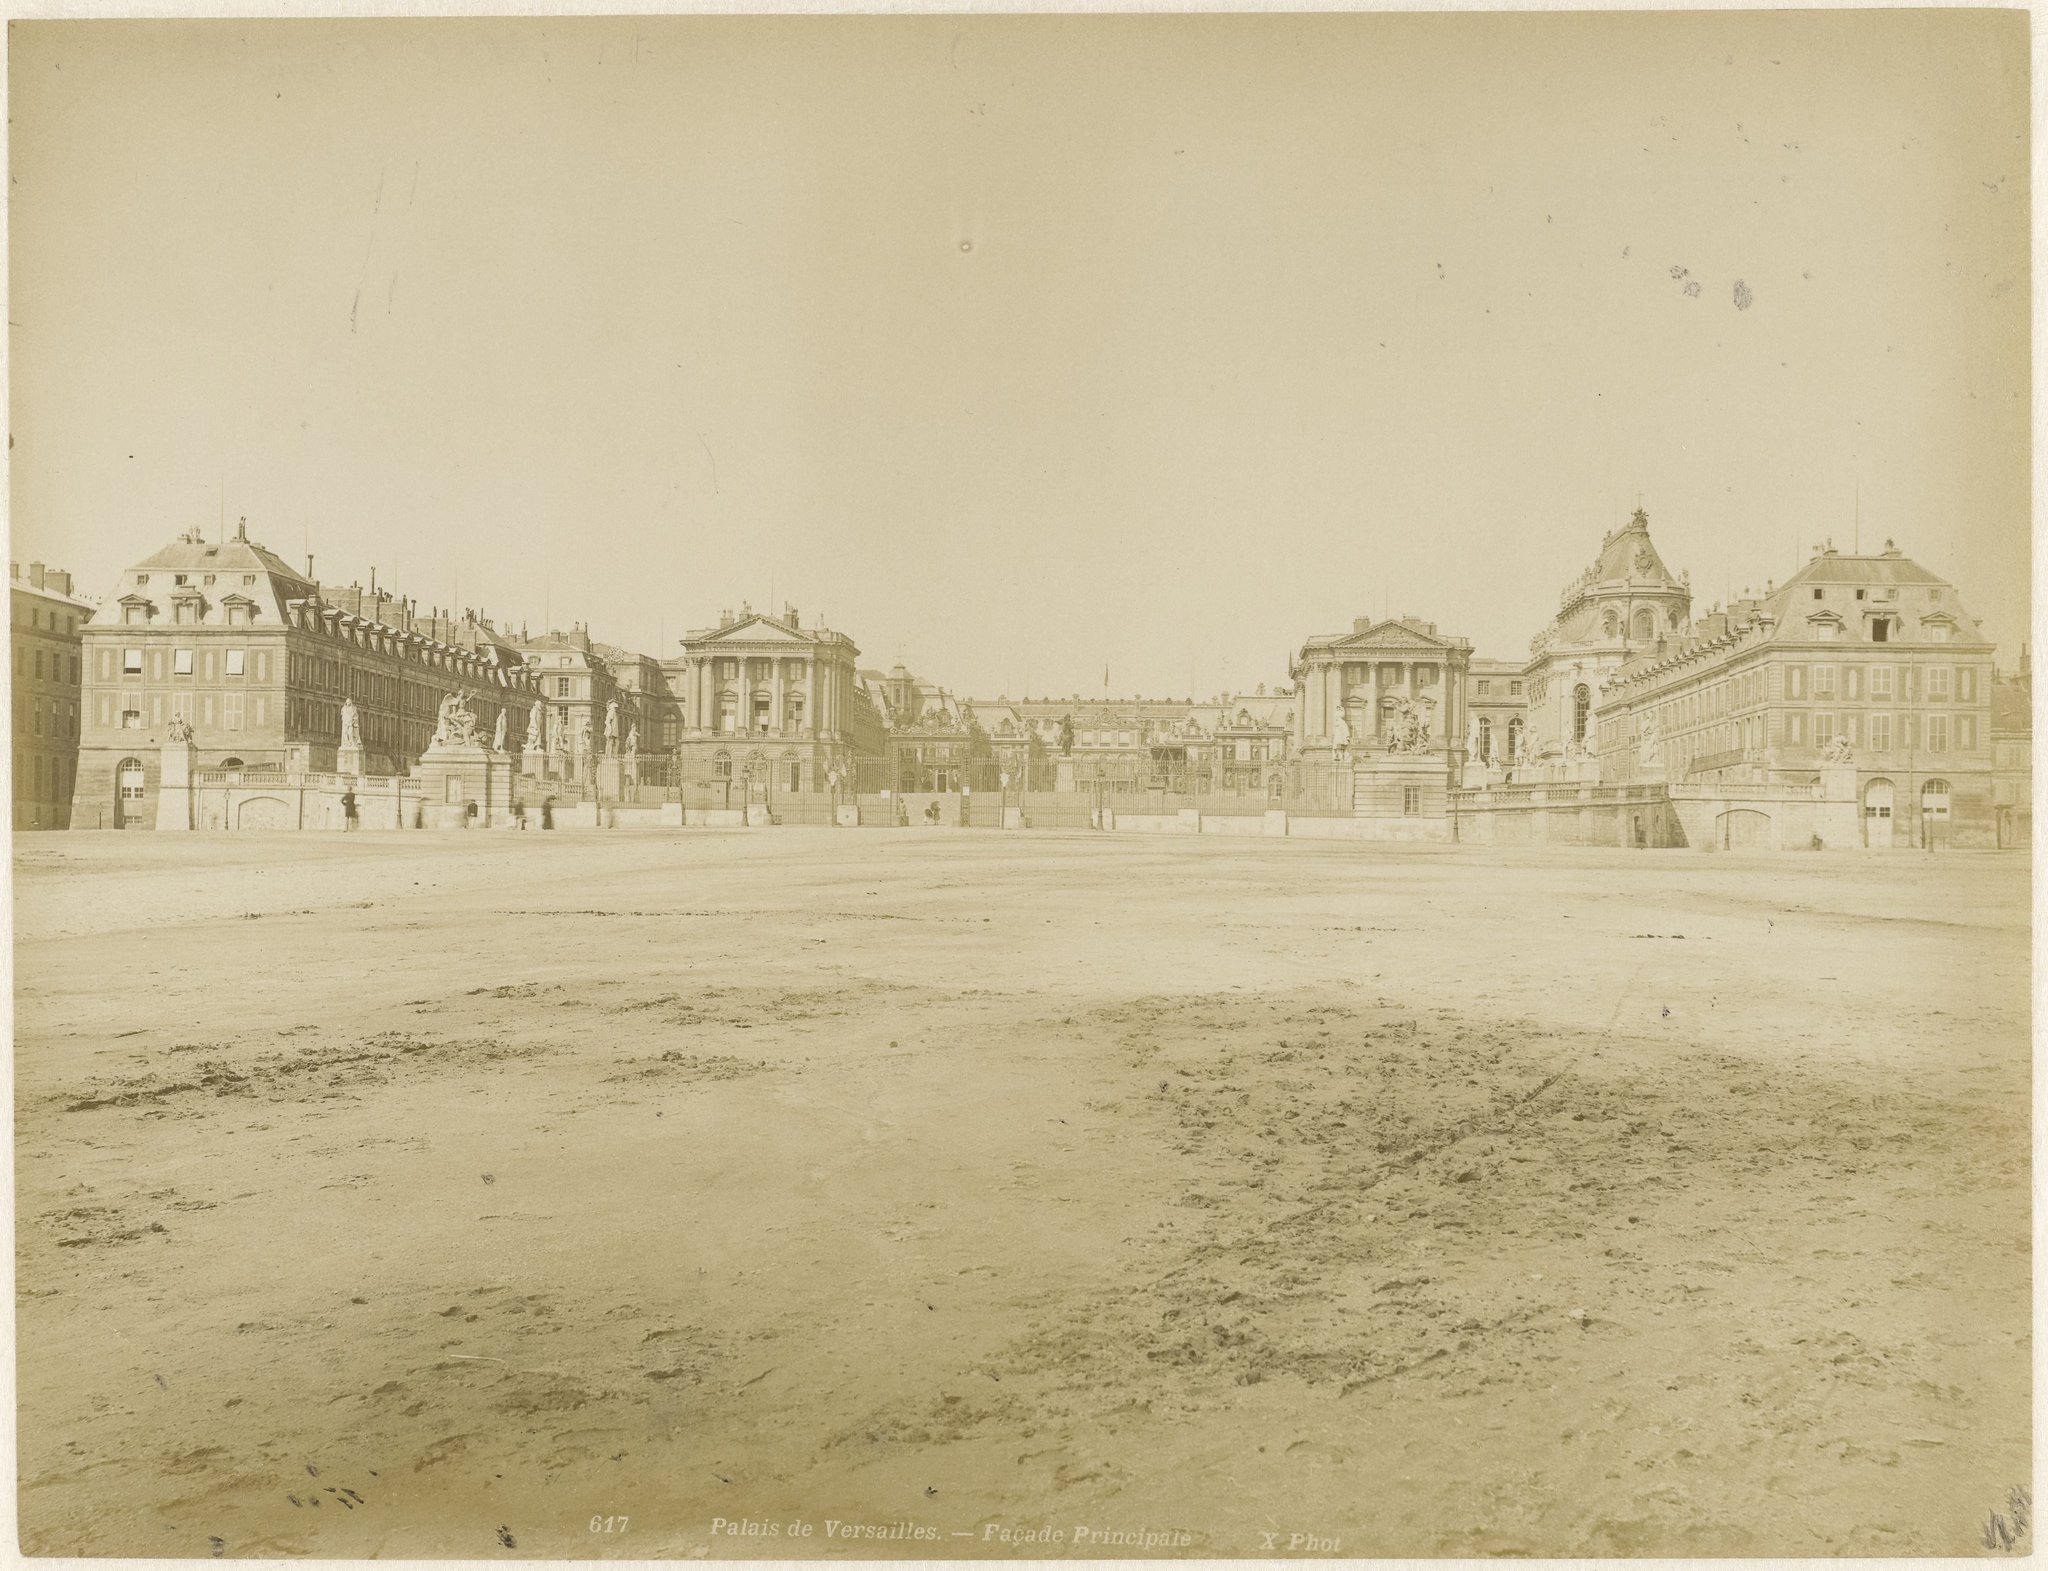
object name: photograph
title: Palais de Versailles - façade principale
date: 1887-1900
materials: paper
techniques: albumen print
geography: versailles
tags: palace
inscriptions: number: ‘617’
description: Tussen 1887 en ca. 1900 werkten Neurdein frères onder andere onder de naam 'X phot.'.